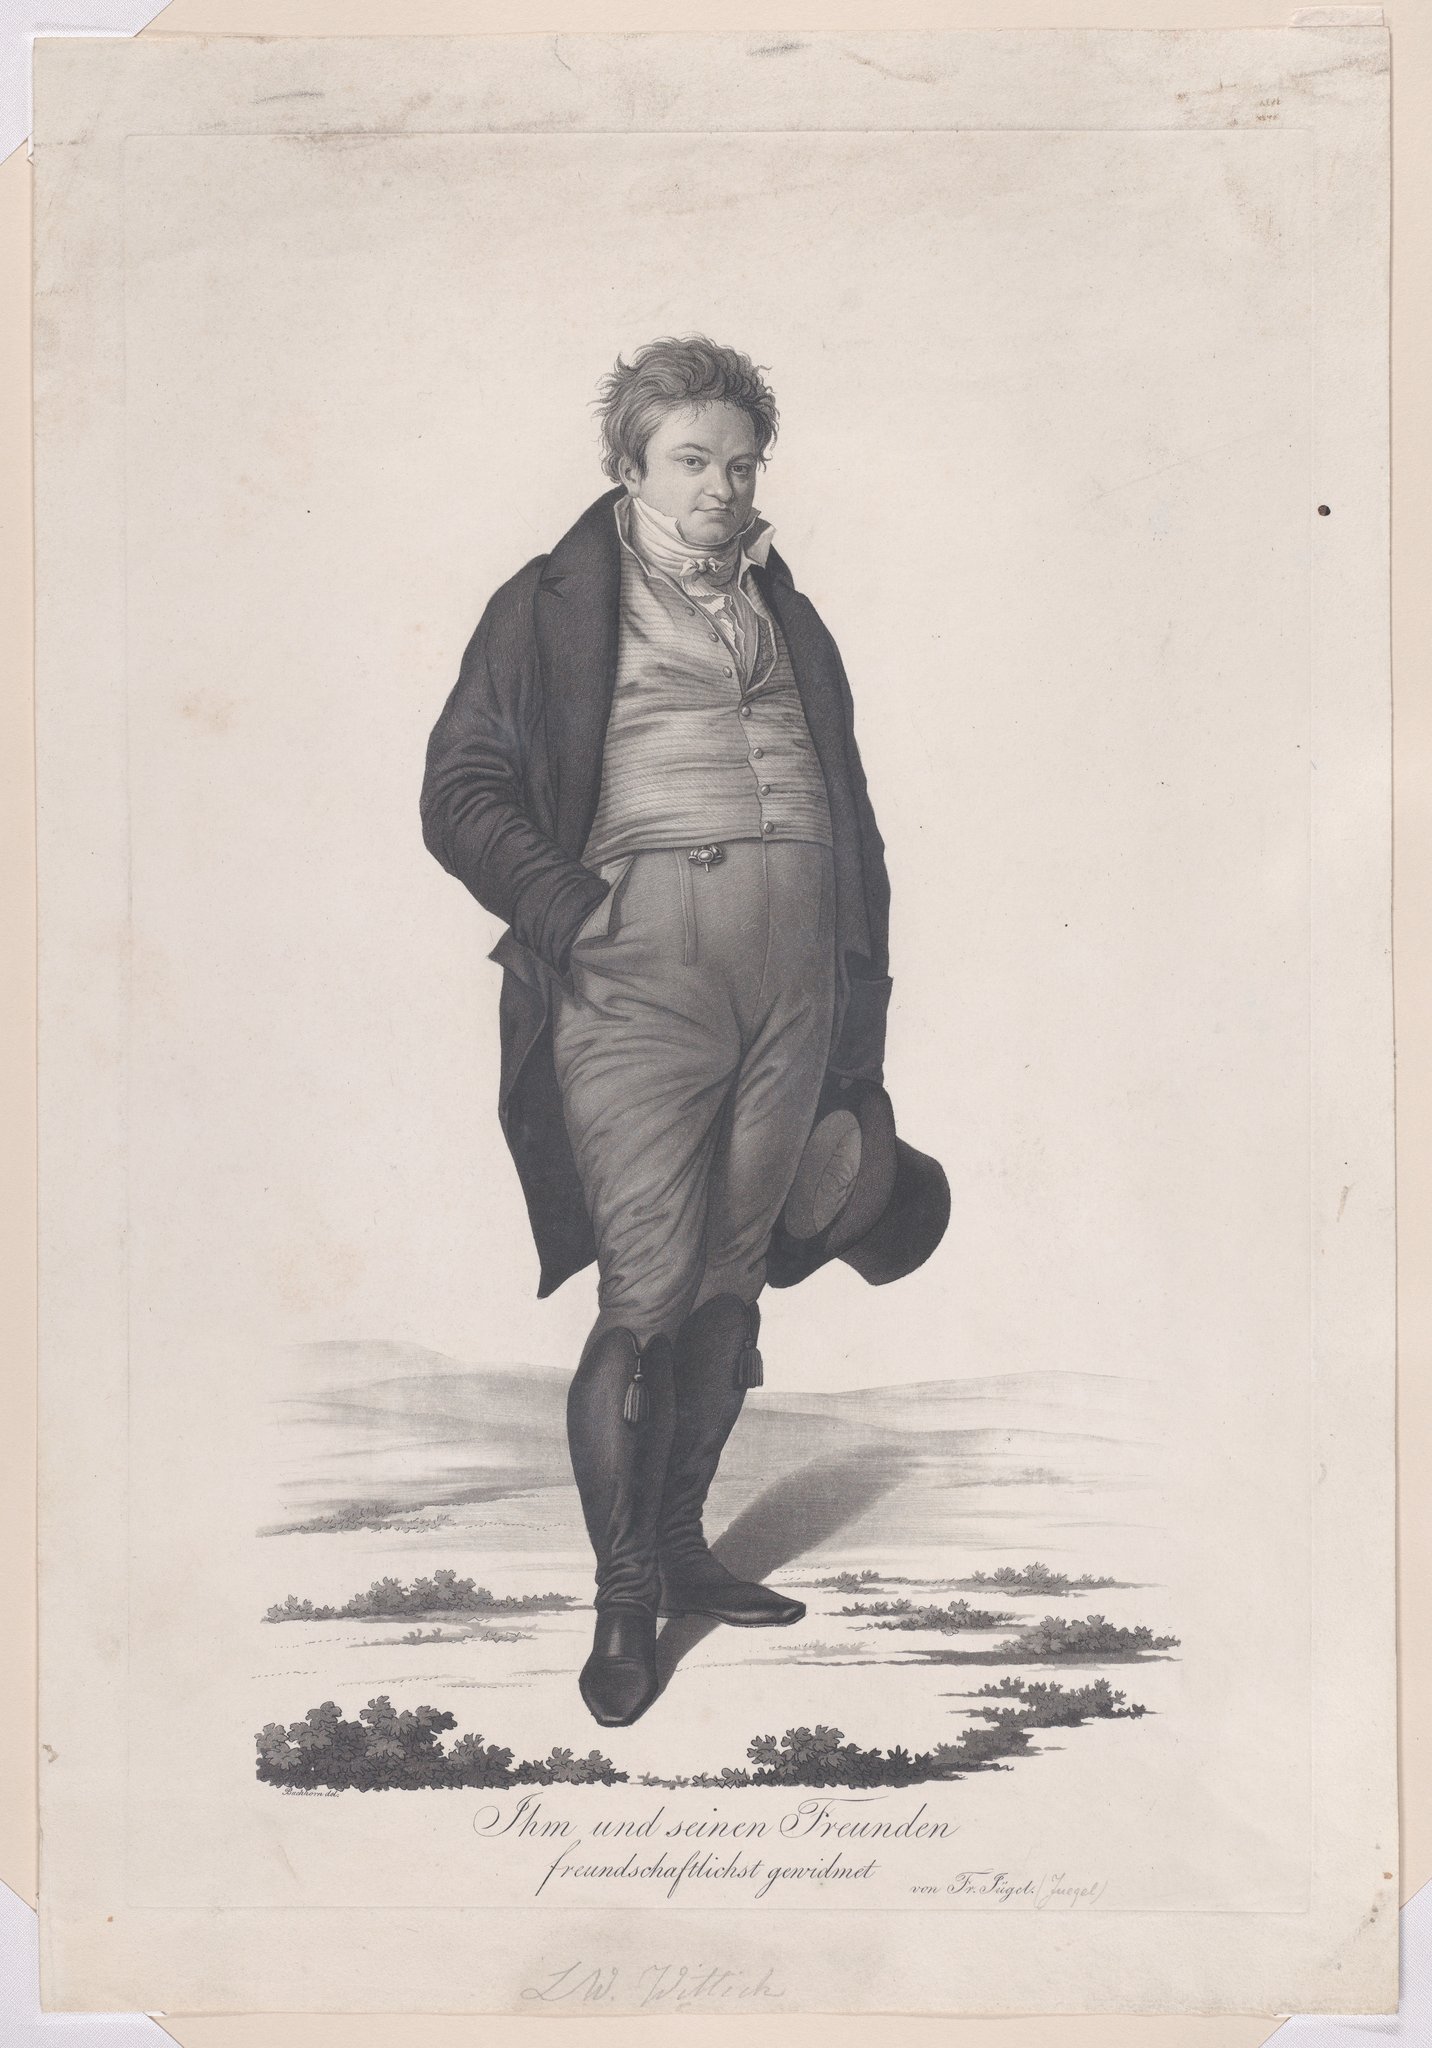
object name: print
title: Ludwig Wilhelm Wittich, Art Dealer and Publisher in Berlin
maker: friedrich jügel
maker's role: print maker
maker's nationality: german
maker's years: 1772-1833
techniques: aquatint, etching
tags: men,portraits